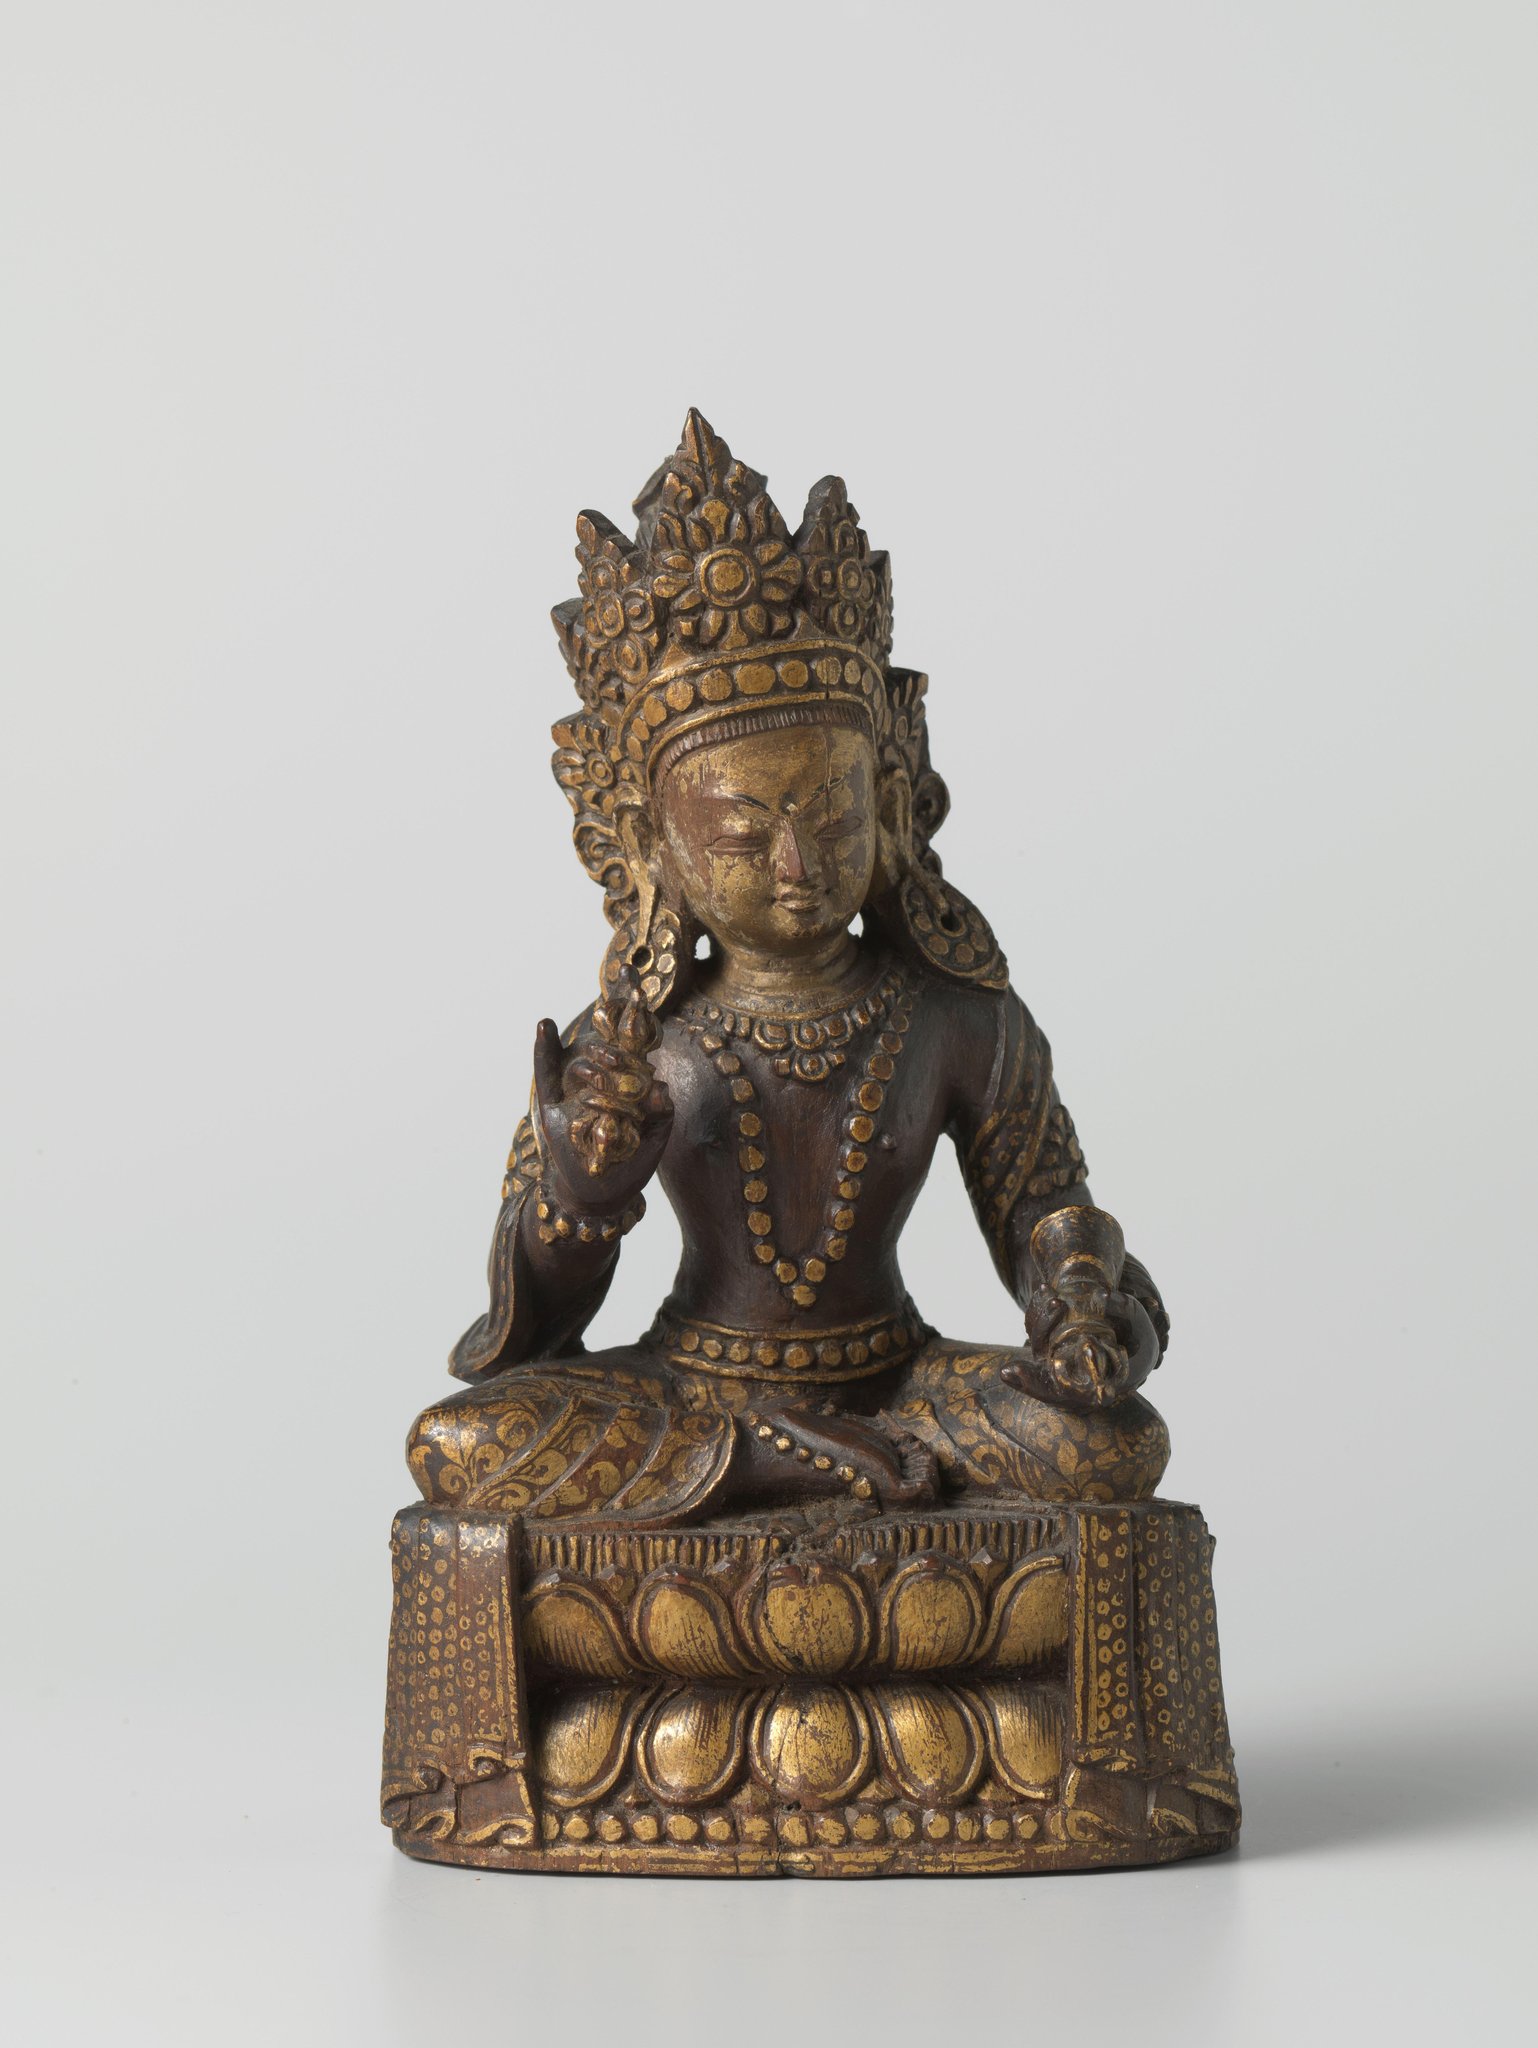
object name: sculpture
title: Vajrasattva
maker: Anonymous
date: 1700-1800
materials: wood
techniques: gilding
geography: nepal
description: Vajrasattva, gezeten op dubbele lotustroon.